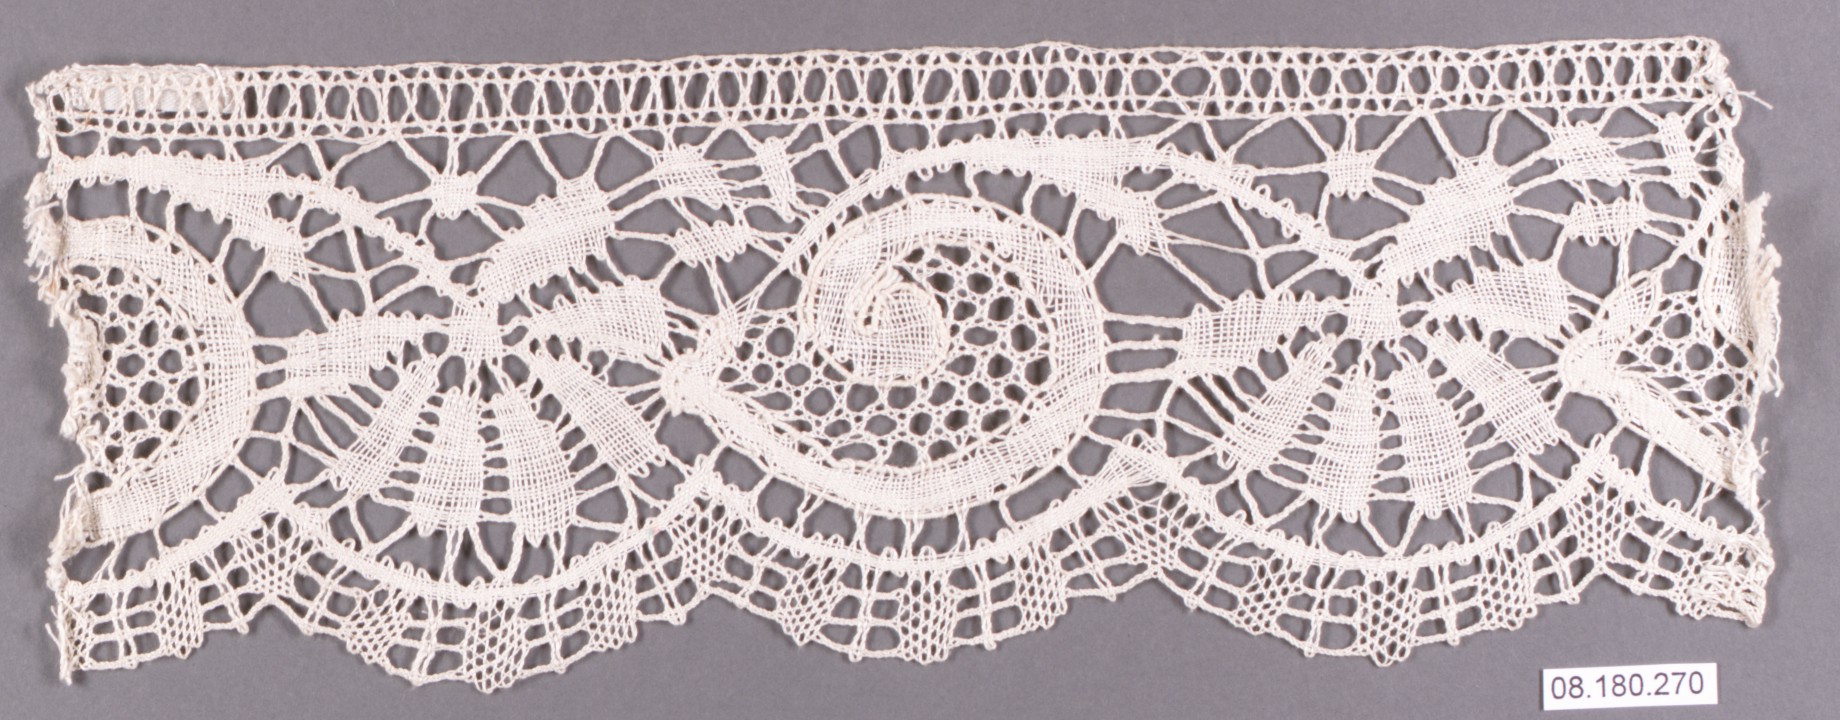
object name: fragment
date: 1801-1900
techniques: lace